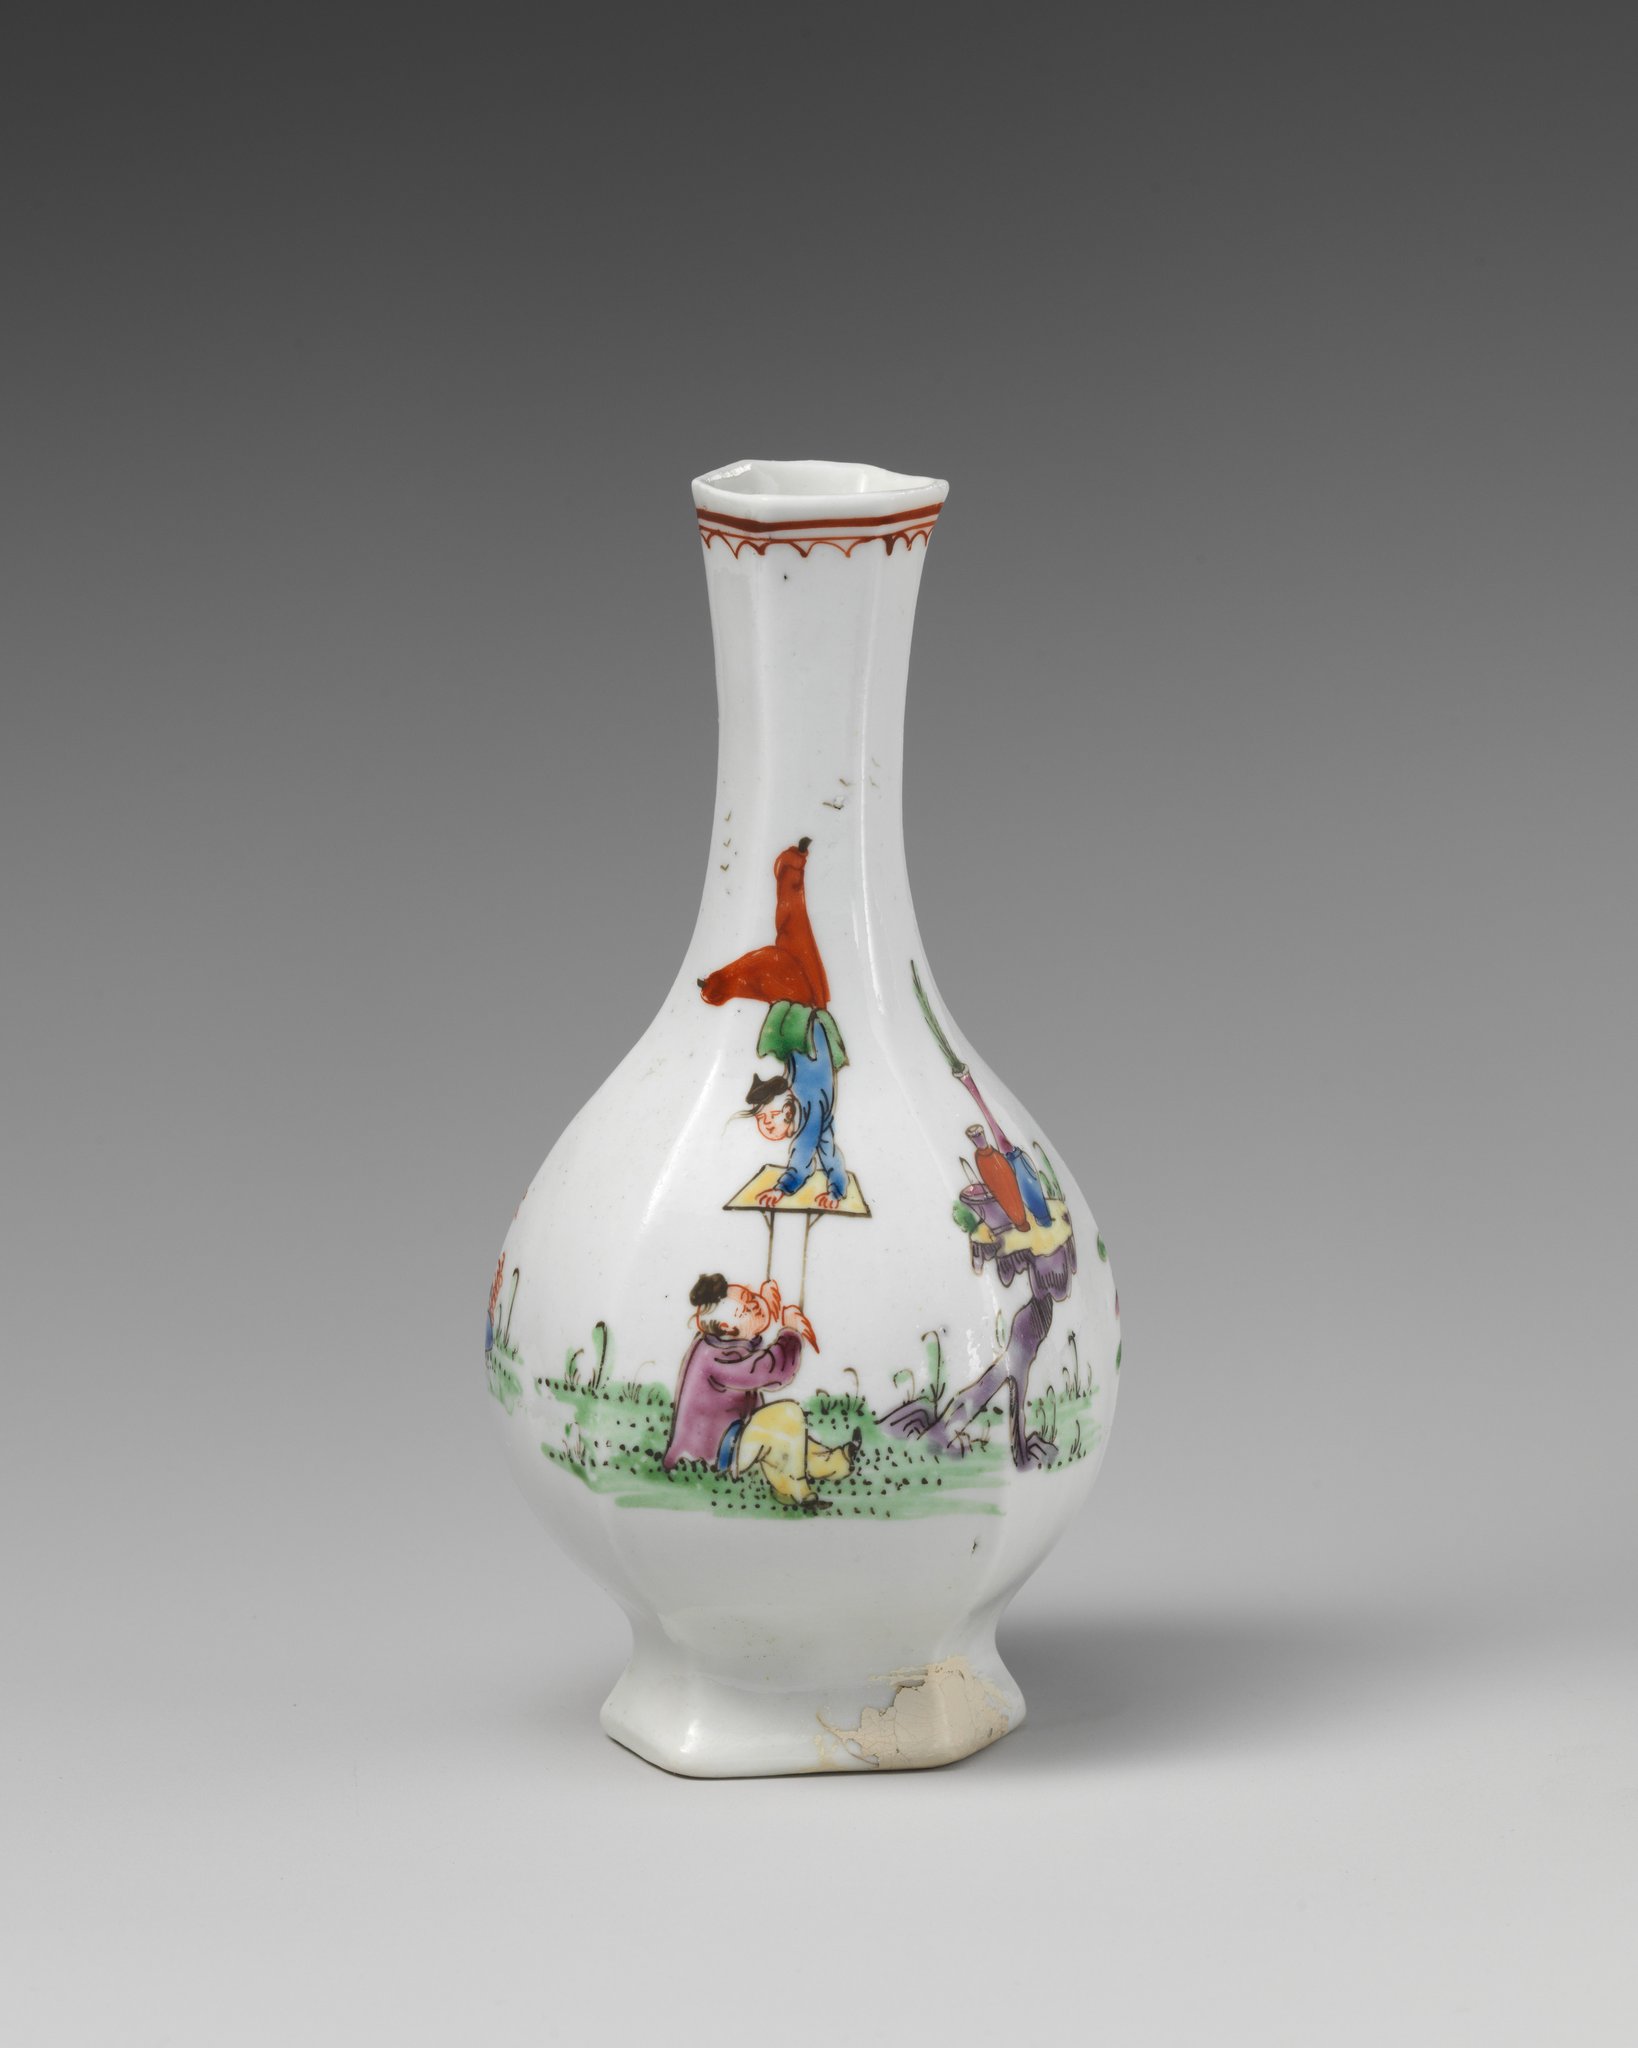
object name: bottle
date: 1701-1800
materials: soft paste porcelain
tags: performance,houses,men